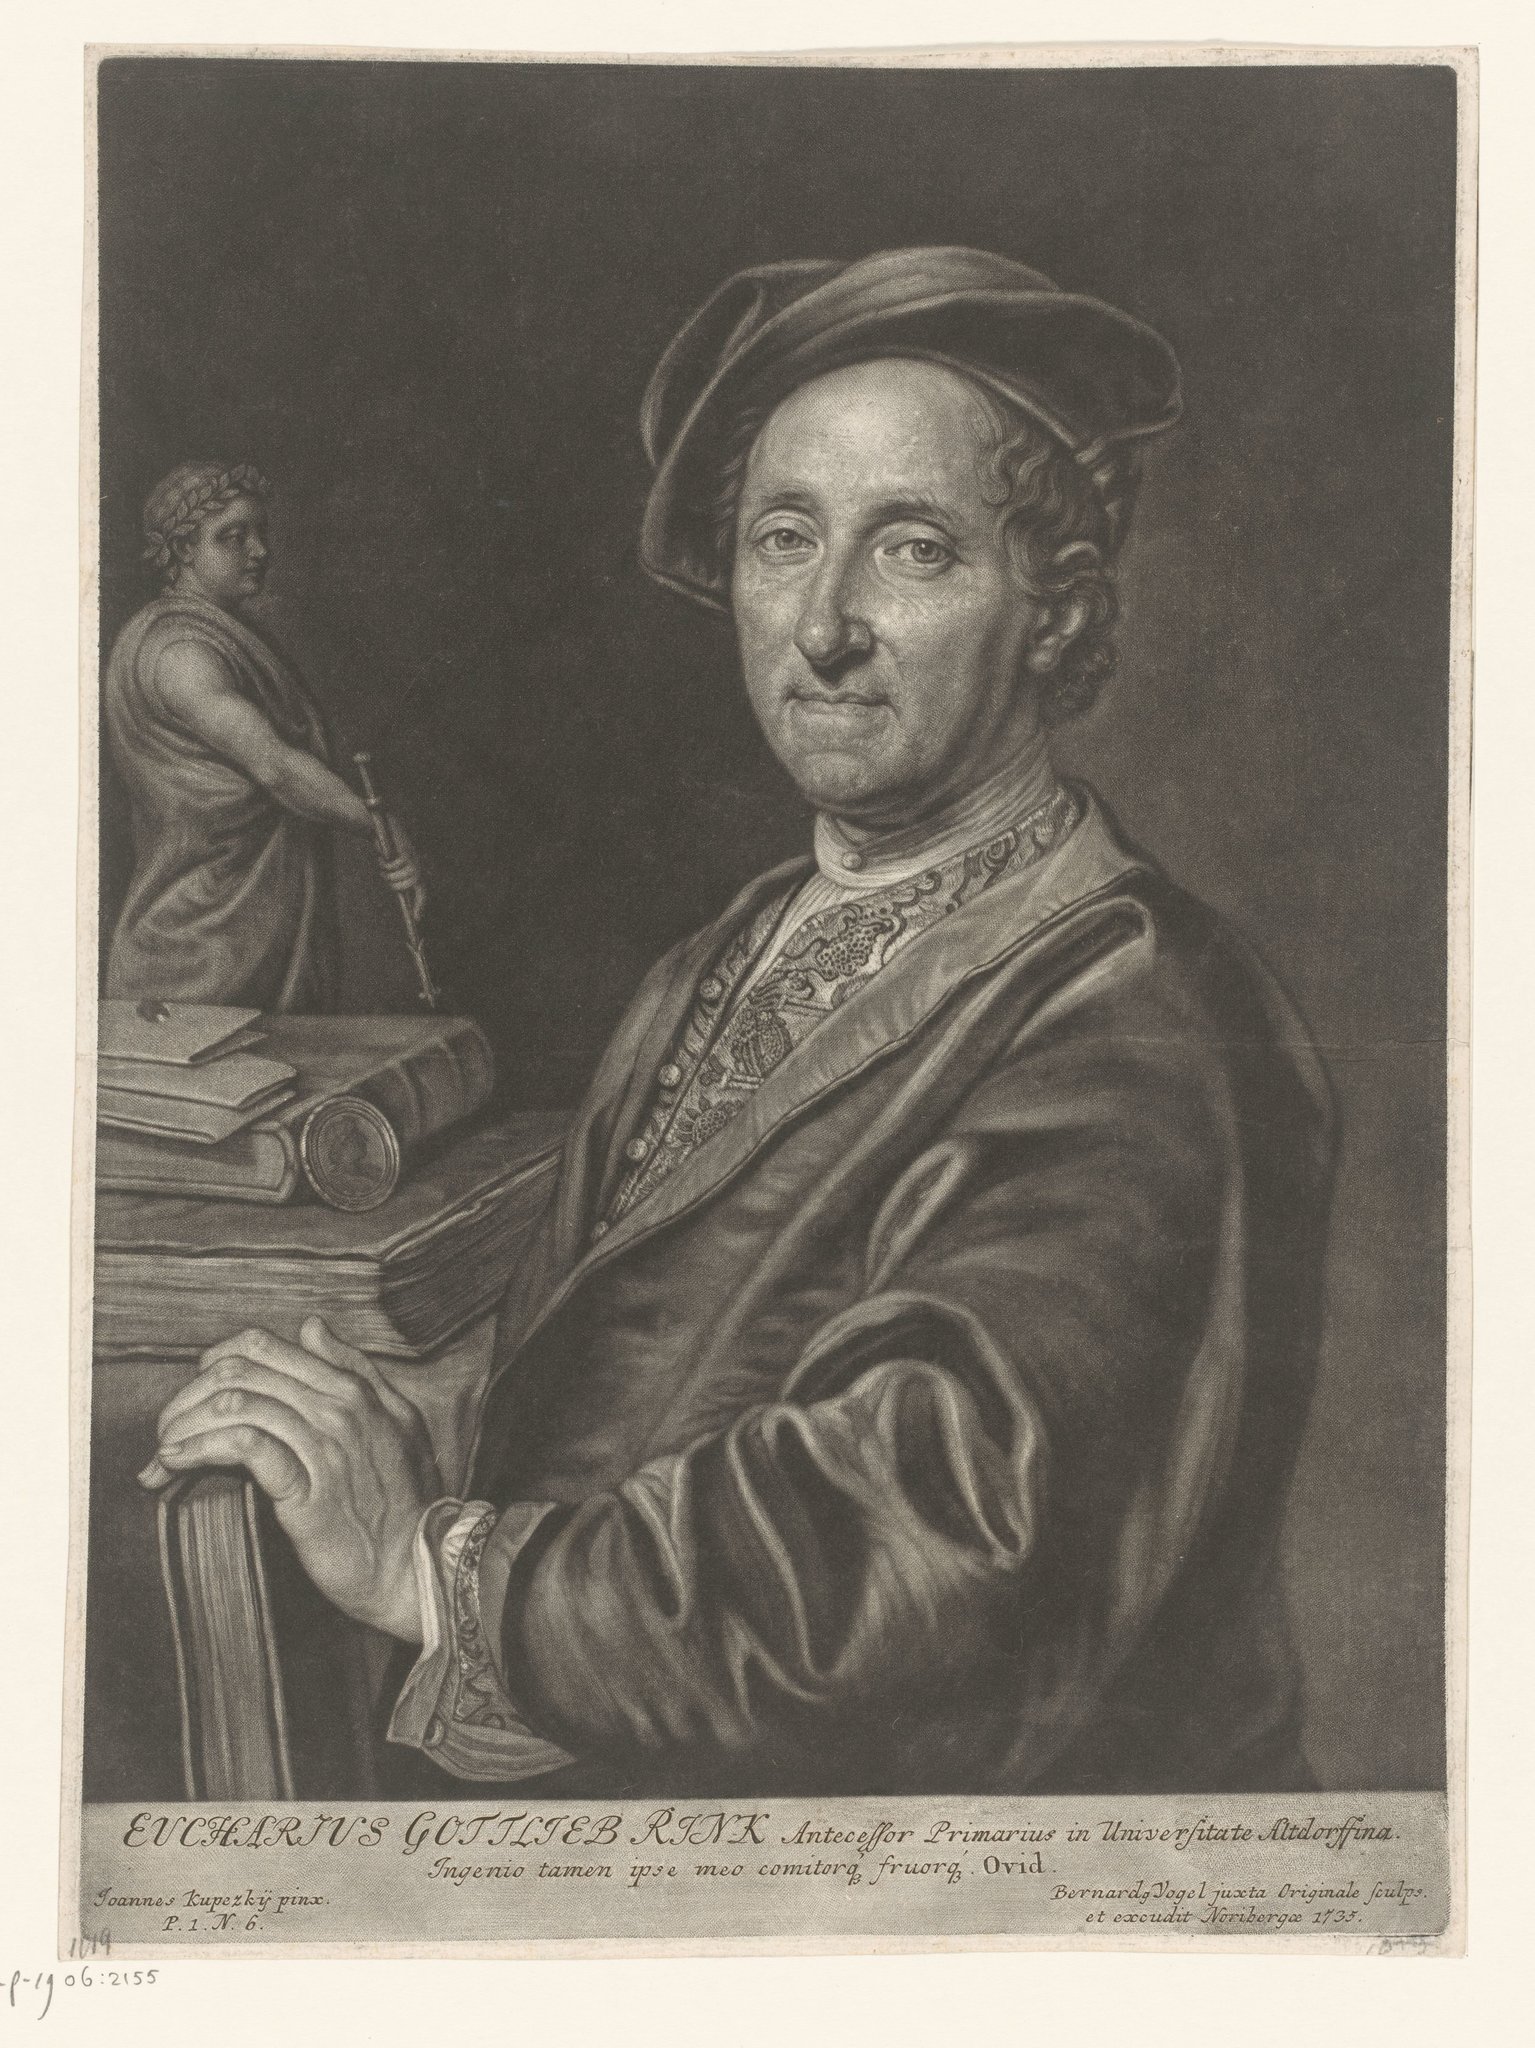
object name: print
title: Portret van Eucharius Gottlieb Rink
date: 1735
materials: paper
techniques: mezzotint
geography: nuremberg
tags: historical persons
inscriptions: collector's mark: Lugt 2228